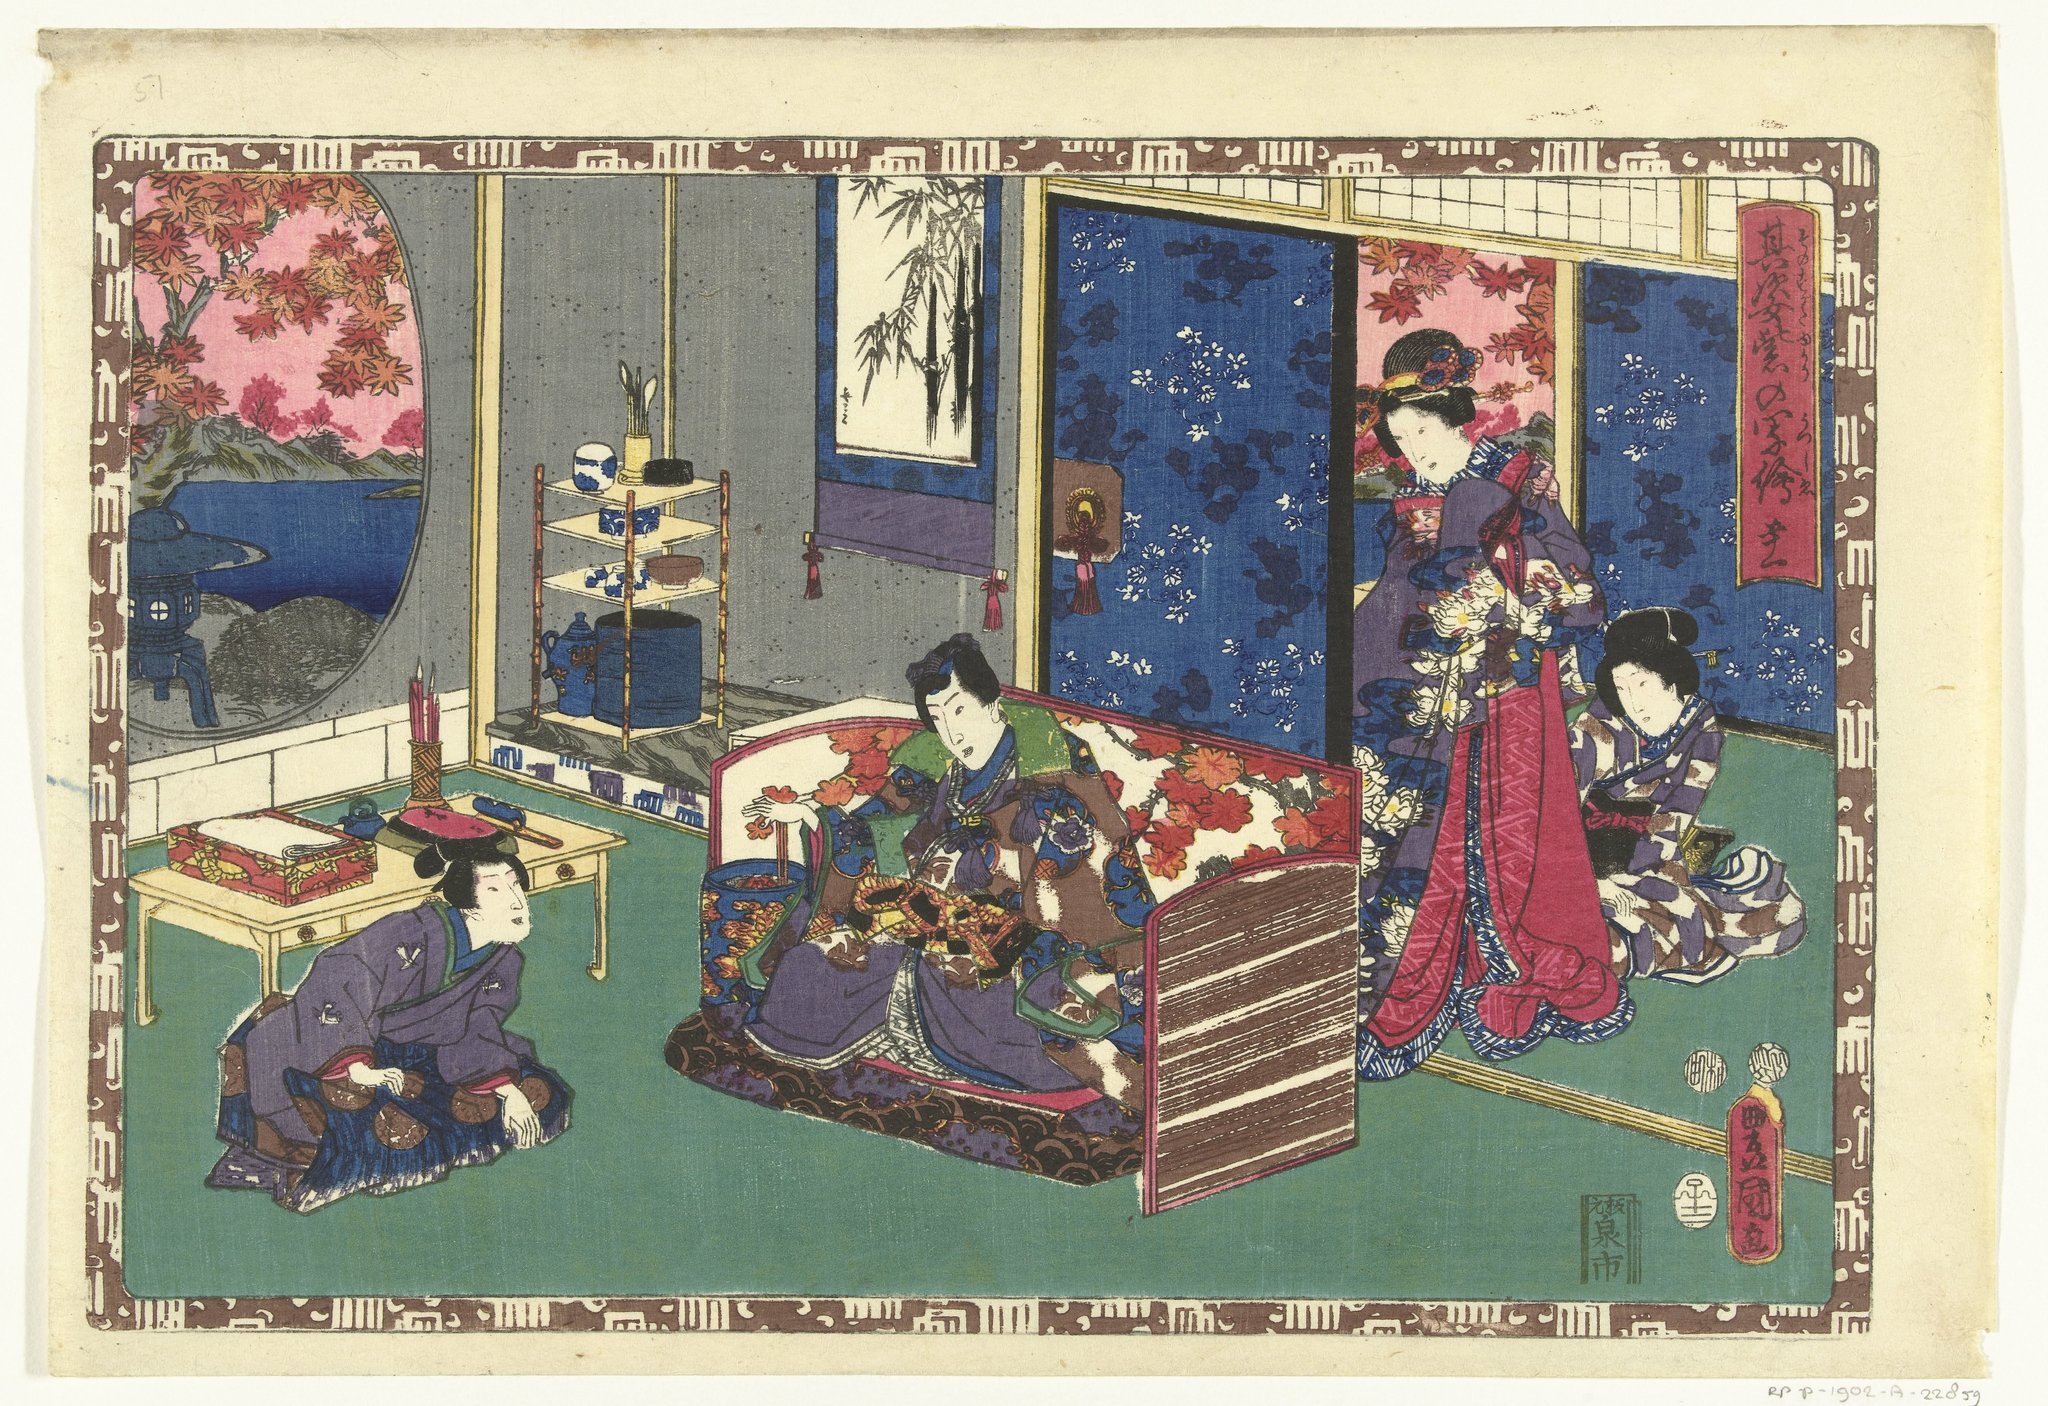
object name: print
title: Getrouwe afbeeldingen van de Schitterende Prins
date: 1852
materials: paper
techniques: woodcut, nishiki e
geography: japan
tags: seating furniture, interior of the house, family life at home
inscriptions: collector's mark: Lugt 2228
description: Elegant geklede man zittend op bank, kijkend naar knielende man; twee vrouwen toekijkend vanachter een schuifdeur. Voorstelling omsloten door bruine rand waarin Genji emblemen.